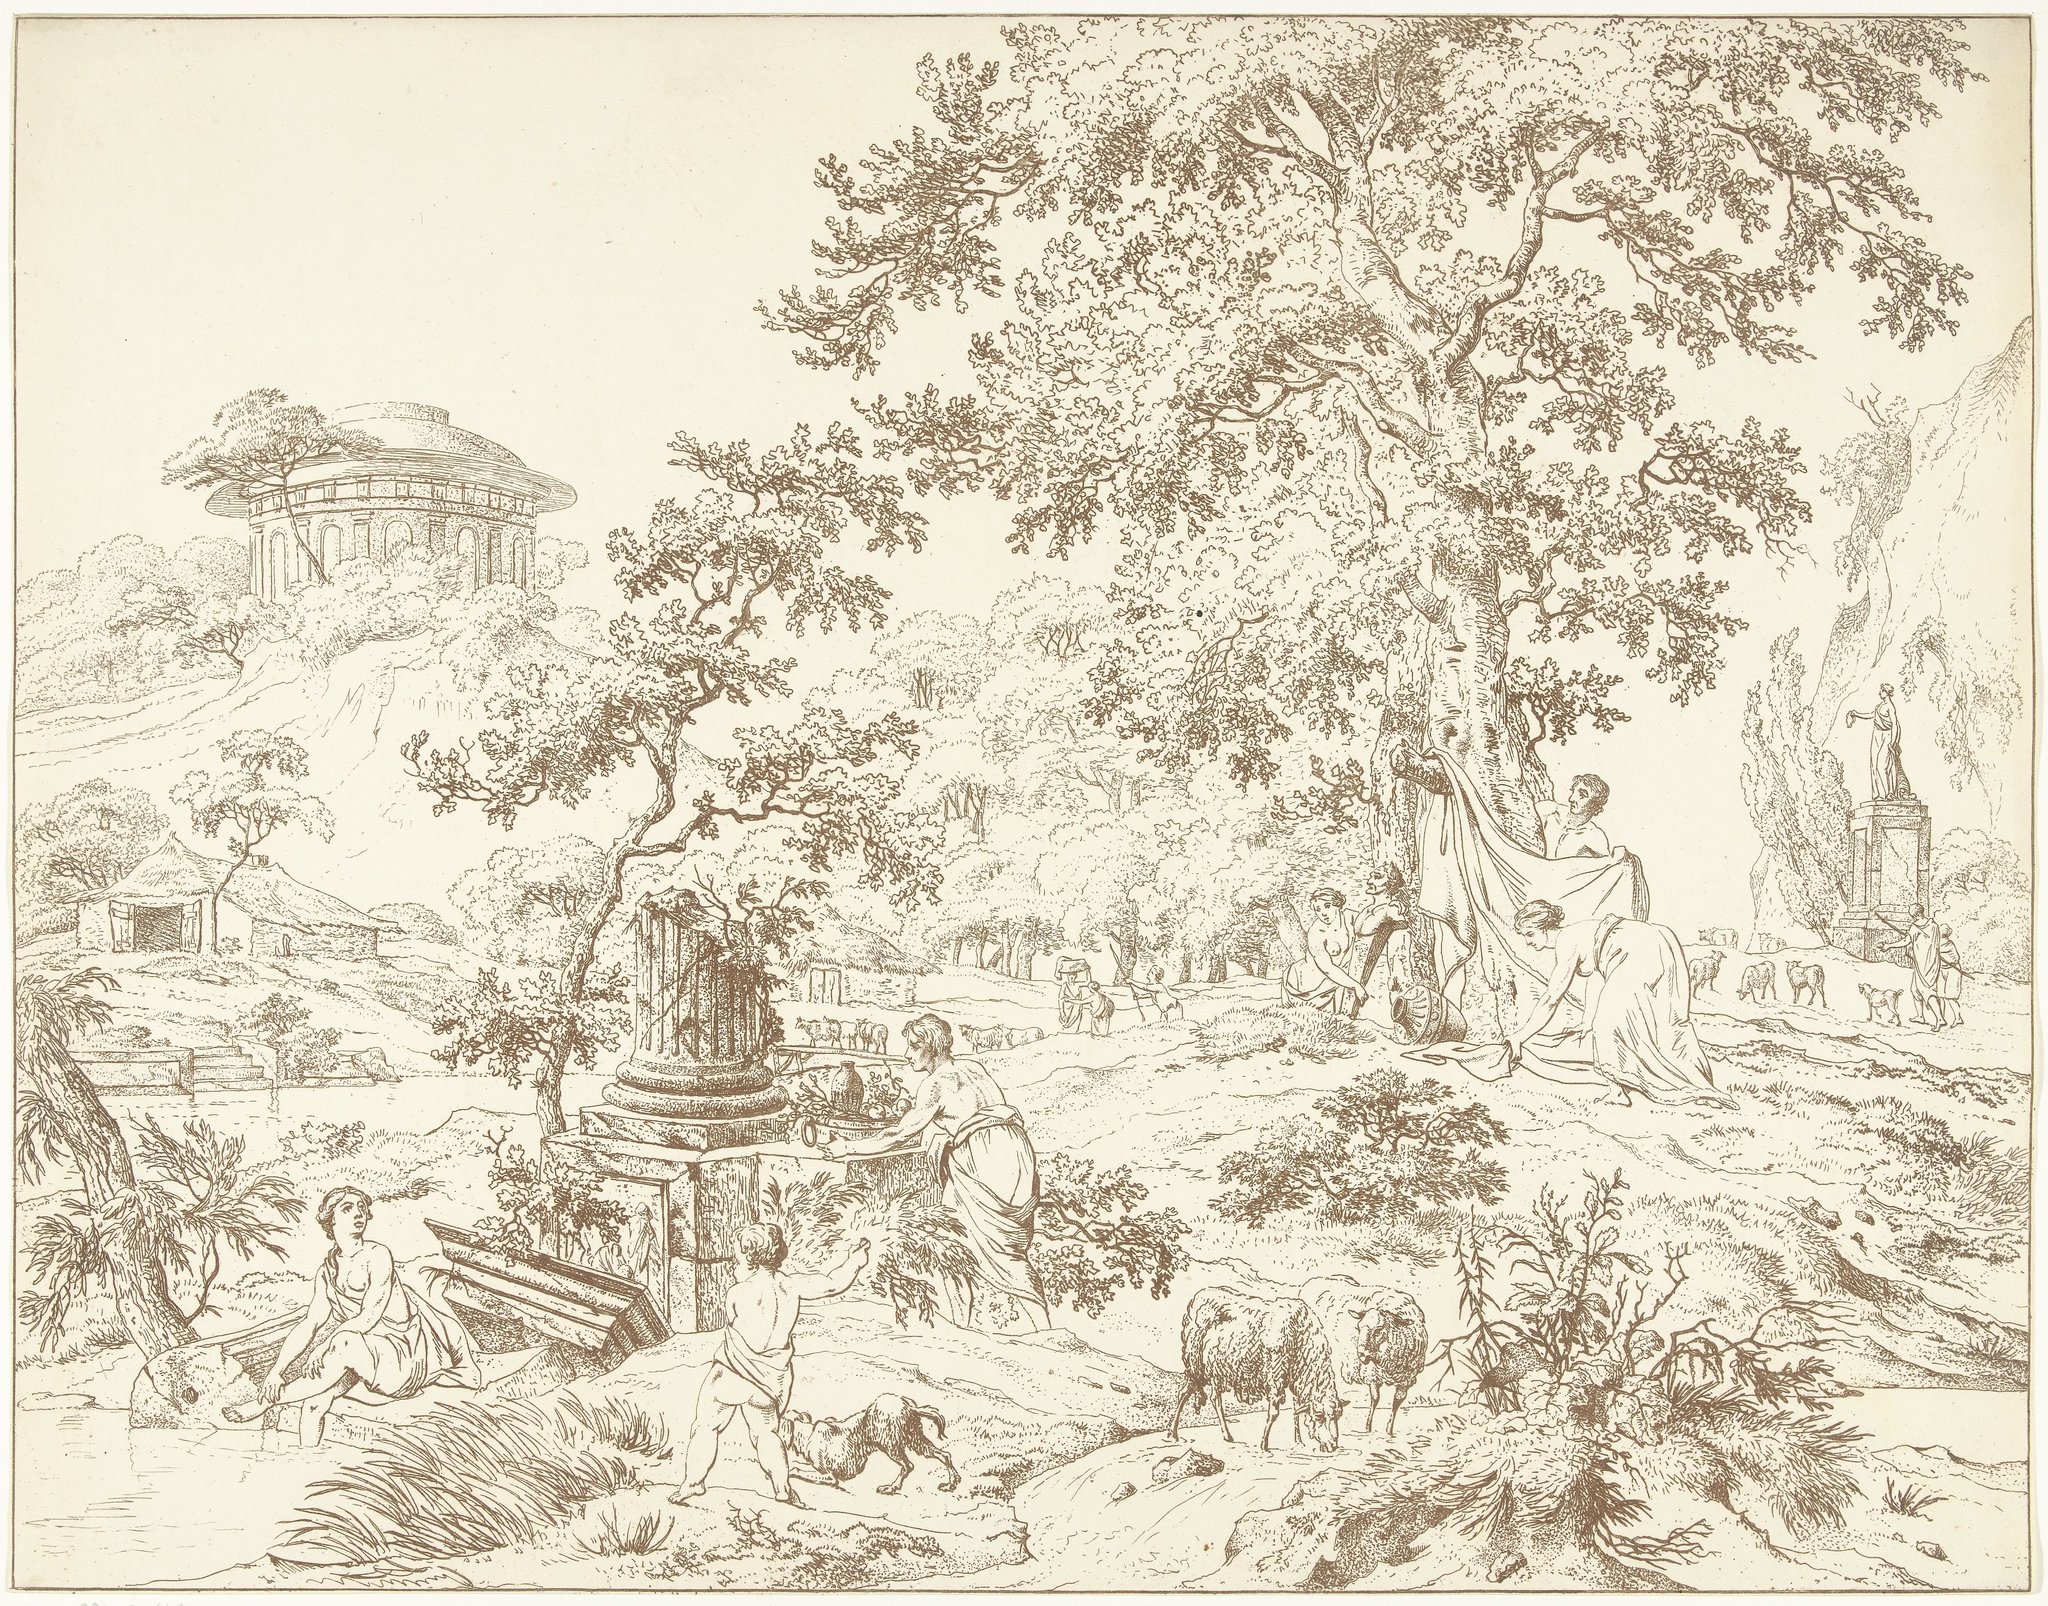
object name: print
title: Arkadisch landschap met voetbadende vrouw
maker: hermanus fock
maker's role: conservator, draughtsman, painter, print maker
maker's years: 1766-1822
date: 1781-1822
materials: paper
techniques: etching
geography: amsterdam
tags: pastorals, arcadian scenes, wading, paddling - aa - female human figure (+ three-quarter view)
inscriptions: collector's mark: Lugt 2228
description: Landschap met verschillende figuren, schapen en een rond gebouw op een berg. Op de voorgrond drinken twee schapen uit een stroompje. Een kind en een hond staan aan de oever van een meertje waar een vrouw haar voeten in baadt. Onder de bomen zijn mannen en vrouwen in de weer met lakens. Op de achtergrond loopt een schaapsherder met zijn kudde langs een beeld op een hoge sokkel.